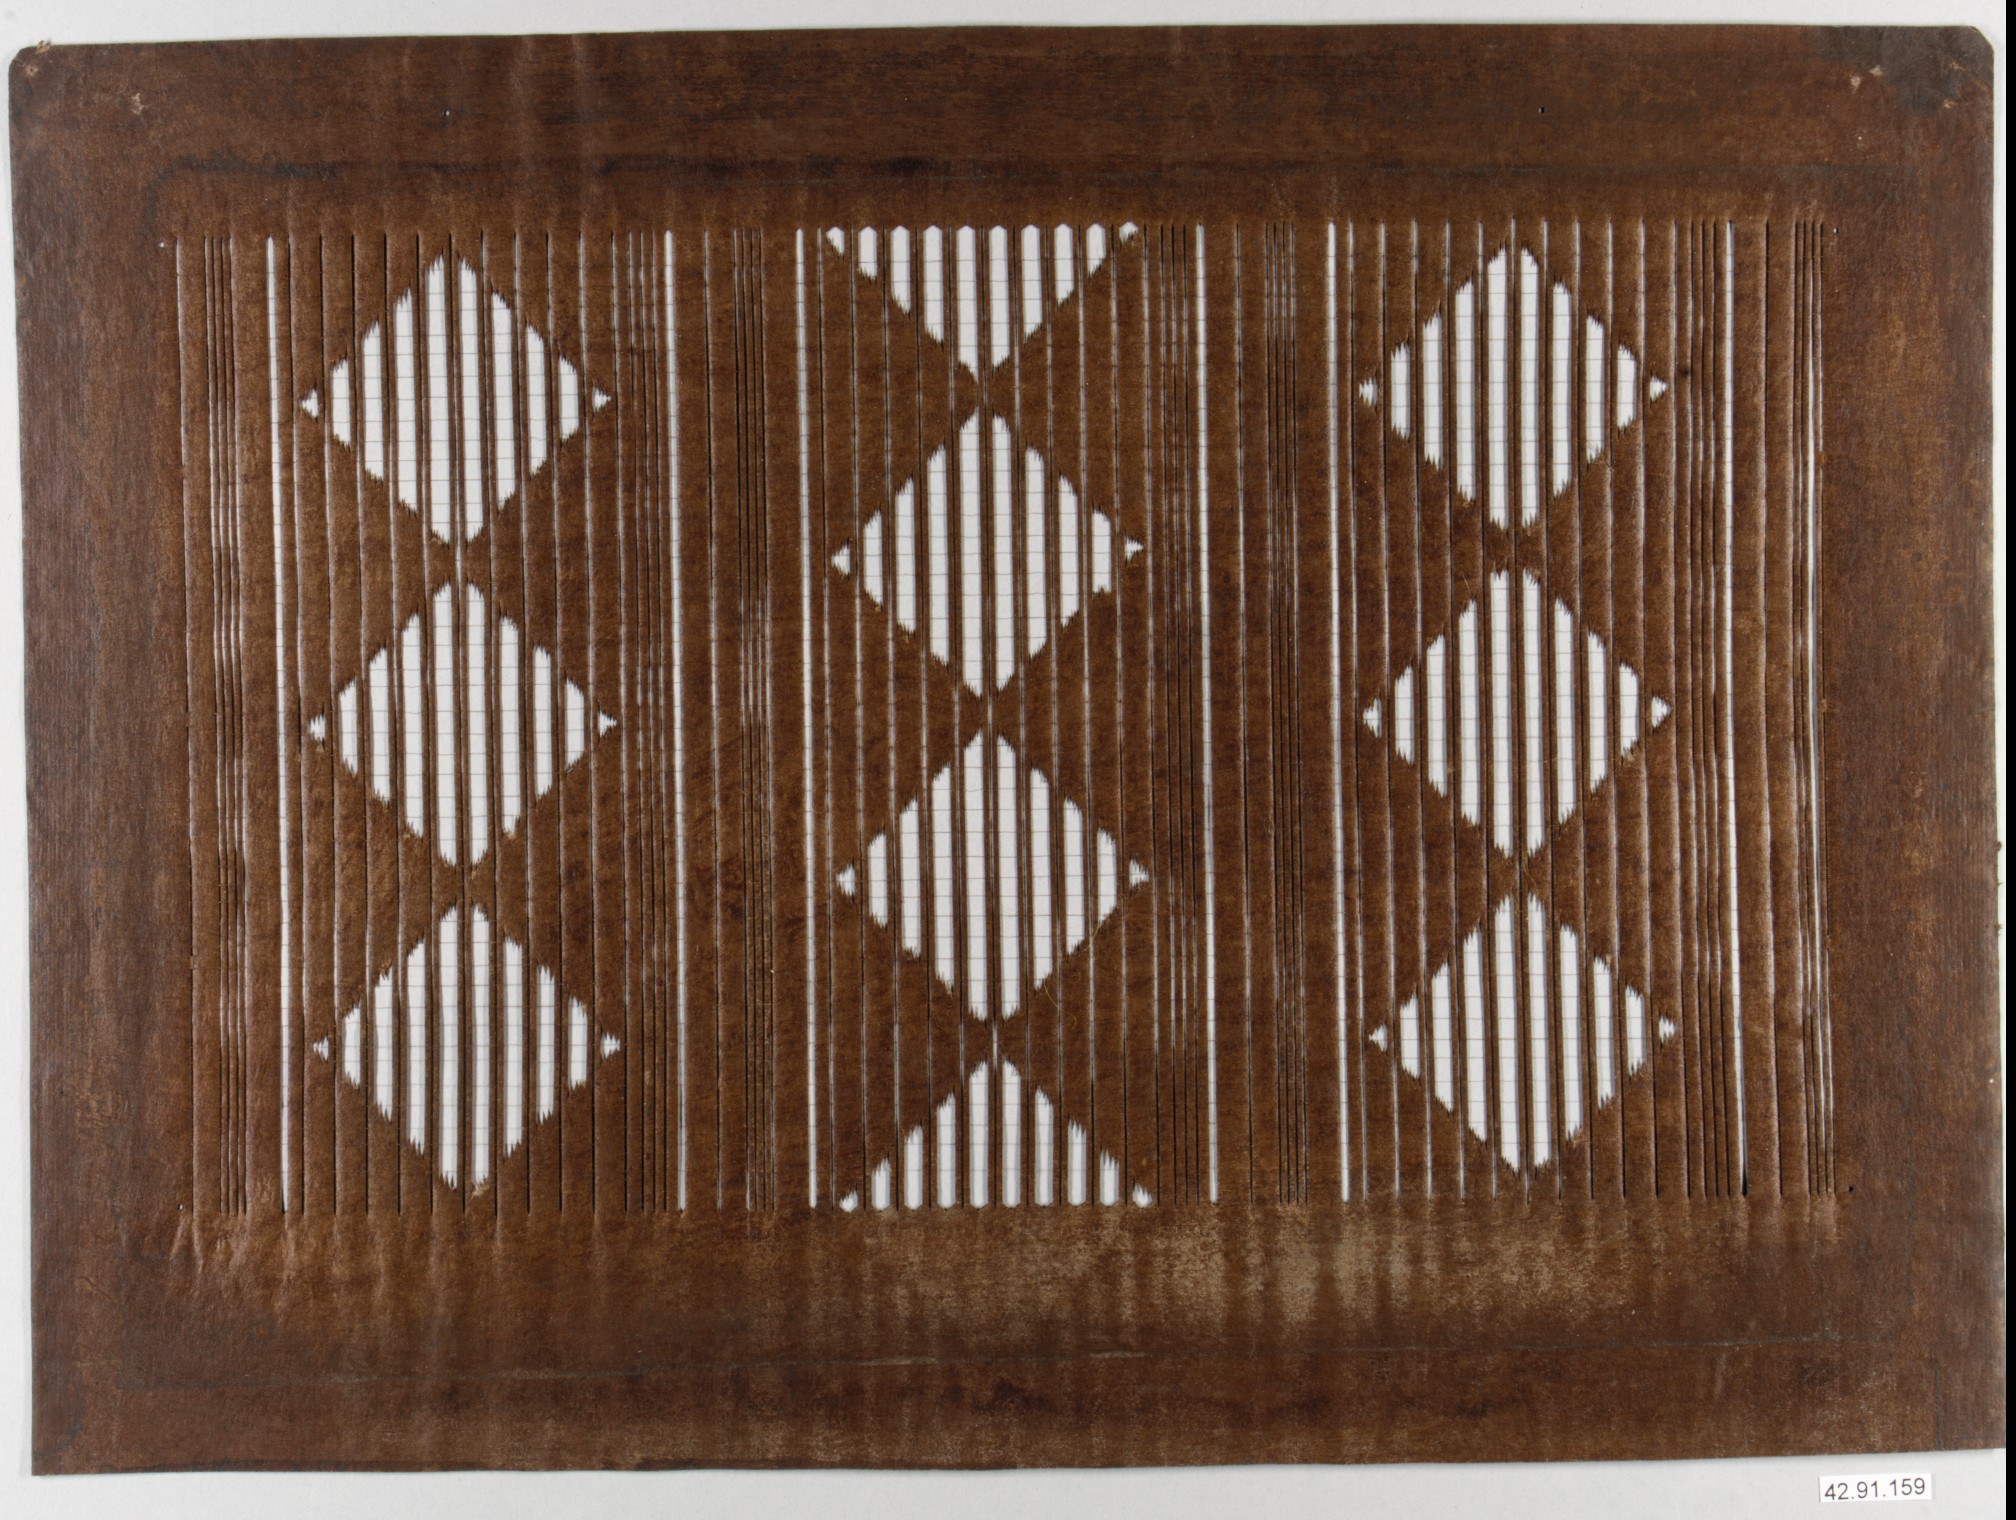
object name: stencil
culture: japanese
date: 1801-1900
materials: paper